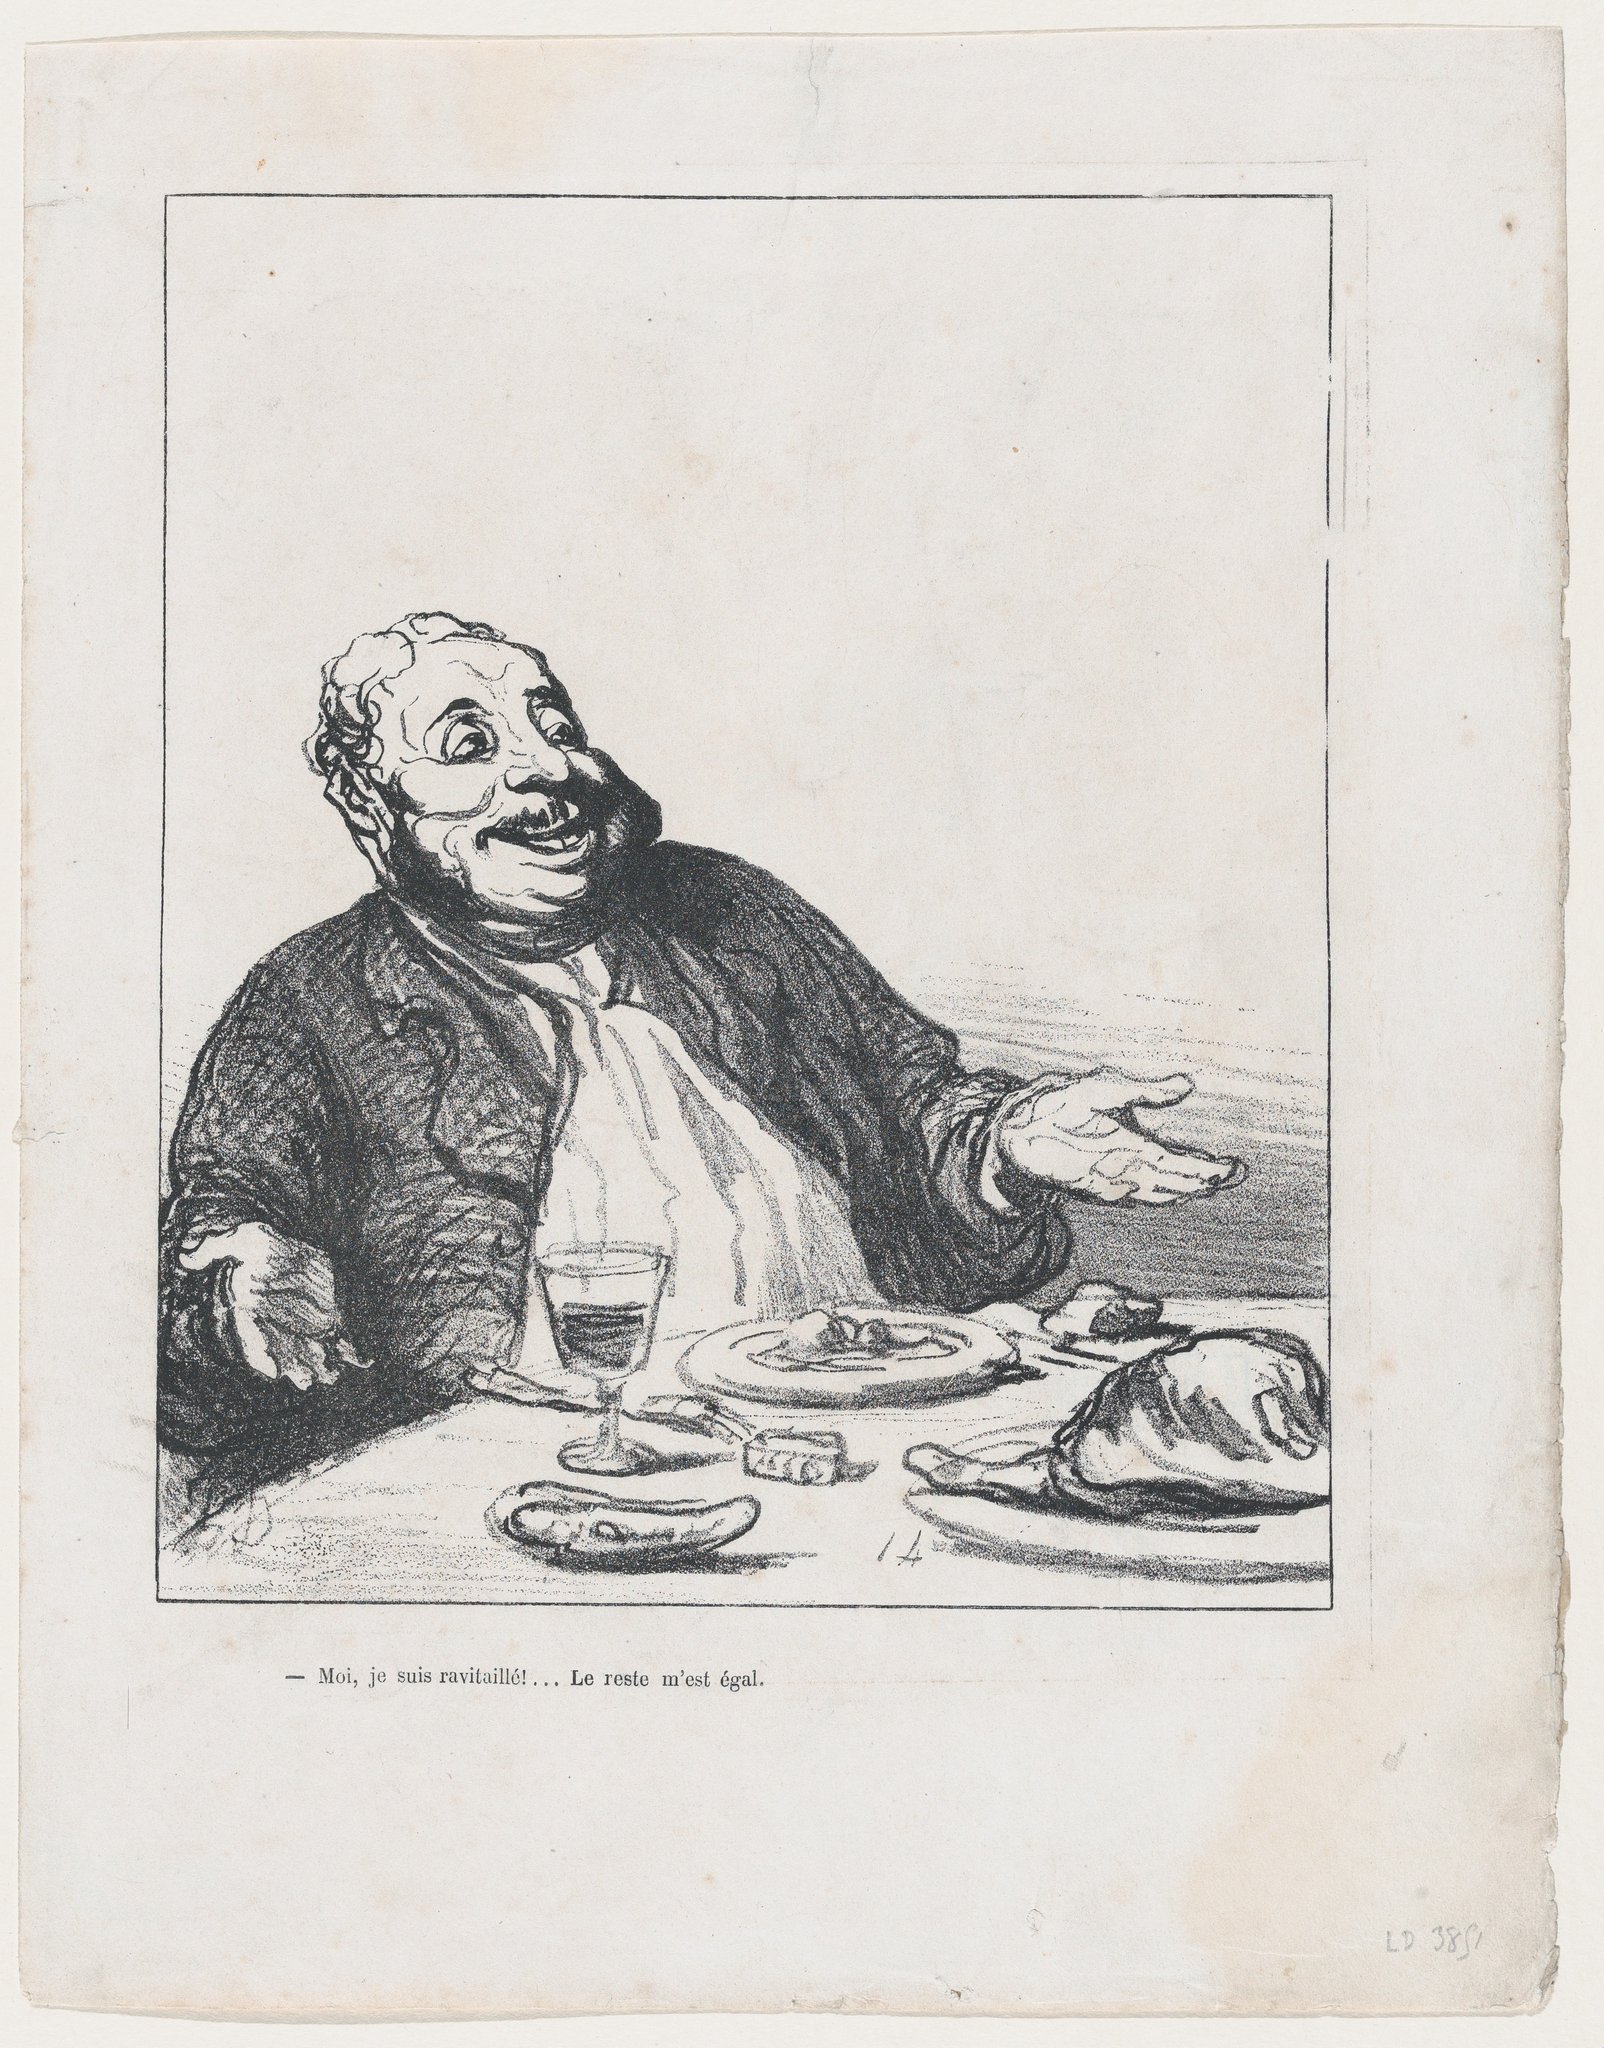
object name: print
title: As for me, I am full... Never mind the rest, published in "L'Album du Siège"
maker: honoré daumier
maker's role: artist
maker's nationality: french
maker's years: 1808-1879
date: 1871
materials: paper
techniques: lithograph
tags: food,men,dining